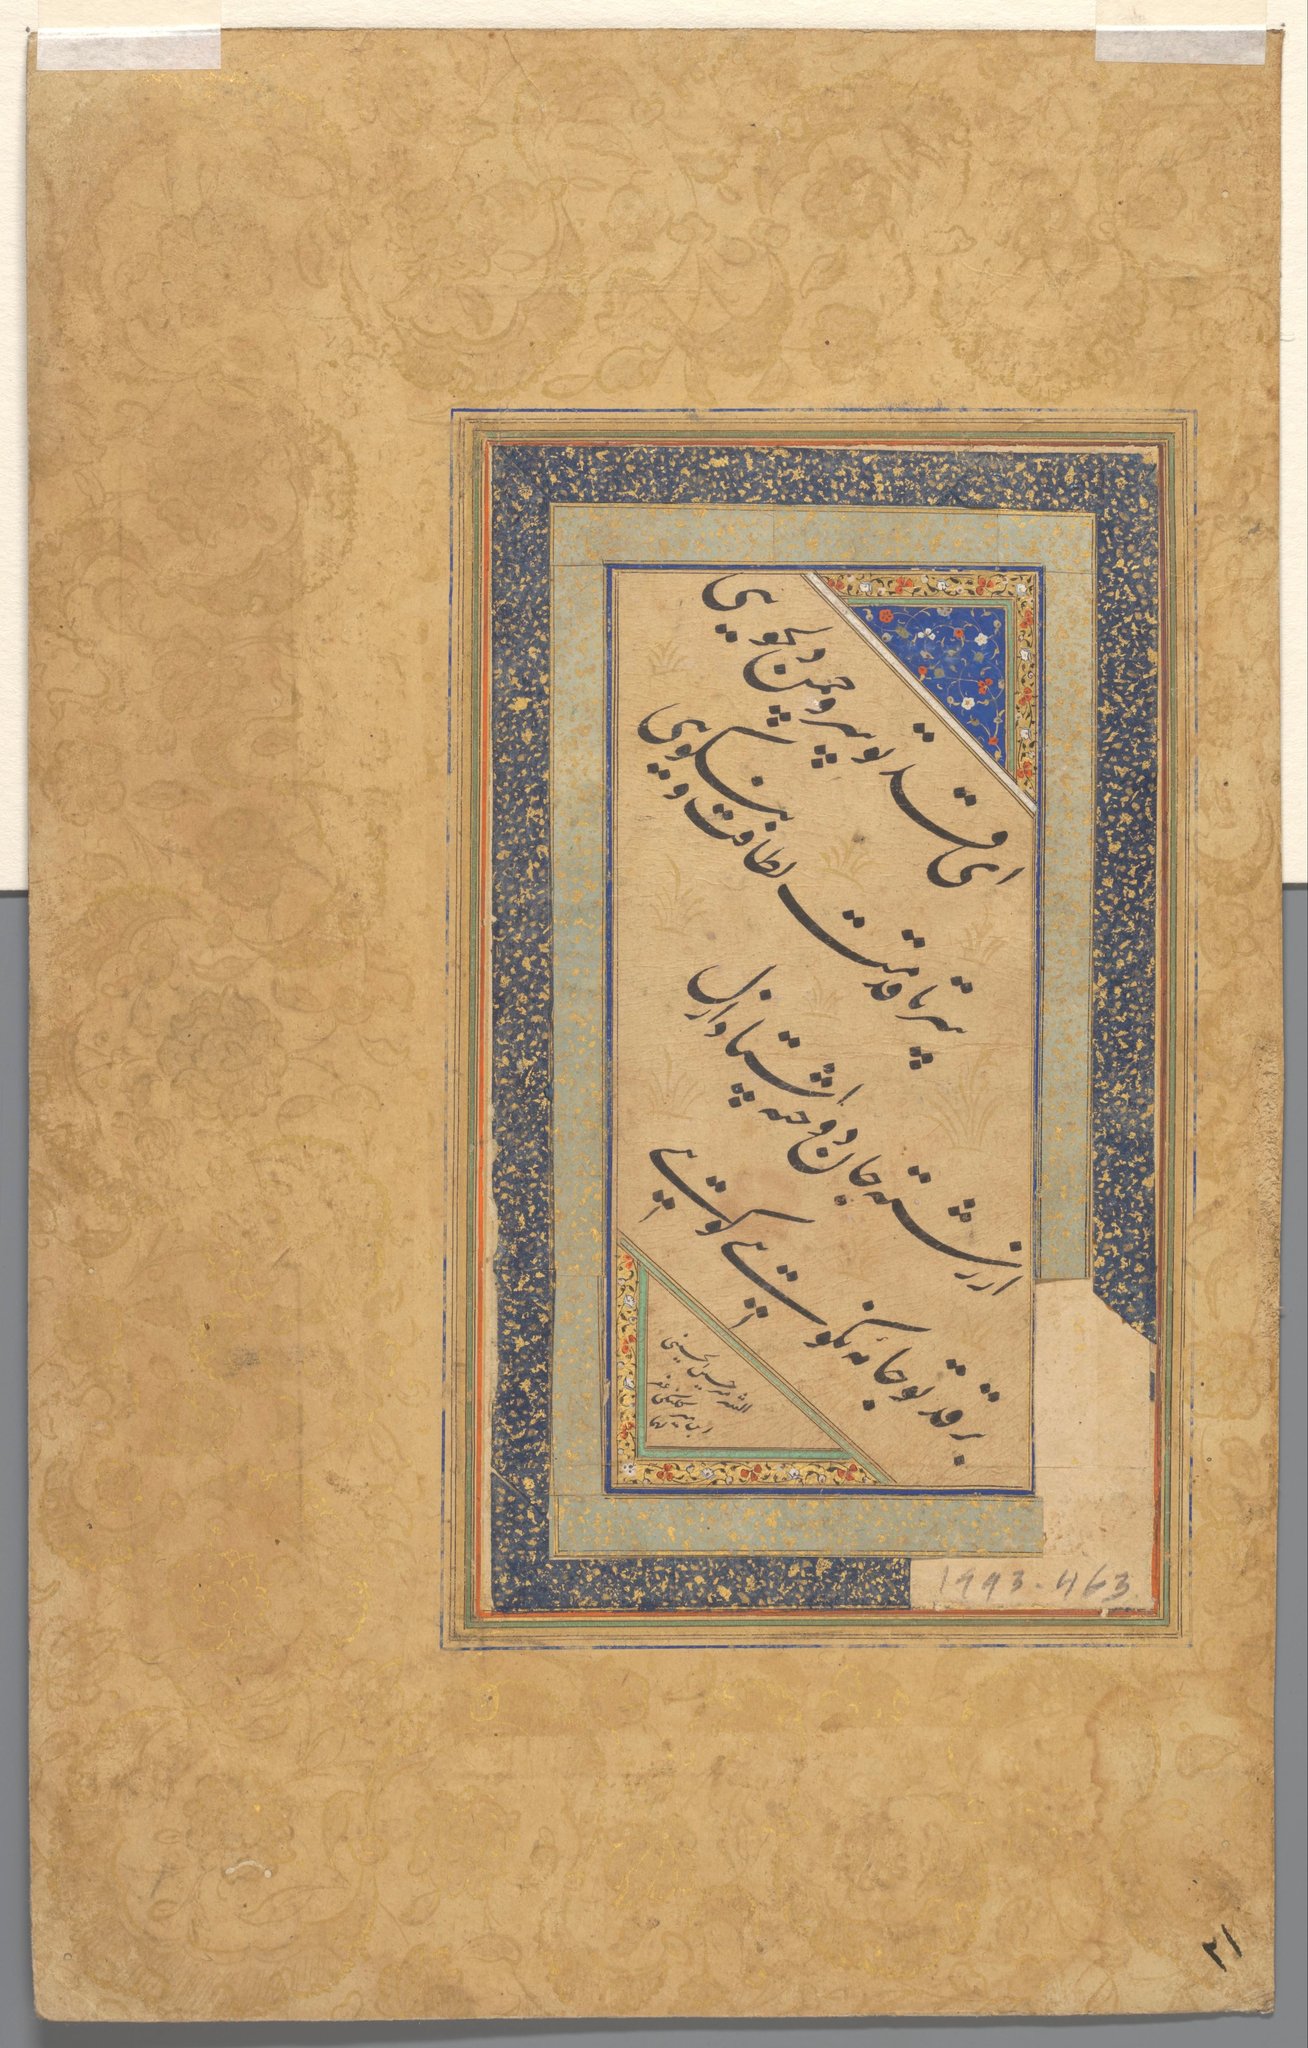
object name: calligraphy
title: Vier diagonale regels Perzische kalligrafie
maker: Anonymous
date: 1500-1700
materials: paper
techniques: brush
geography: iran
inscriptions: inscription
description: In een kader van twee smalle sierranden in hemelsblauw en donkerblauw bespikkeld met goud zijn vier diagonale regels Perzische kalligrafie gezet, linksonder en rechtsboven vormen twee driehoekjes met een smalle gouden sierrand een afsluiting, in de rechterbovenhoek is eveneens een inscriptie gezet; het blad met de kalligrafie is op de linkerkant van een met goudranken dooraderd blad opgeplakt en daarvan gescheiden door met kleuren ingevulde kaderlijntjes